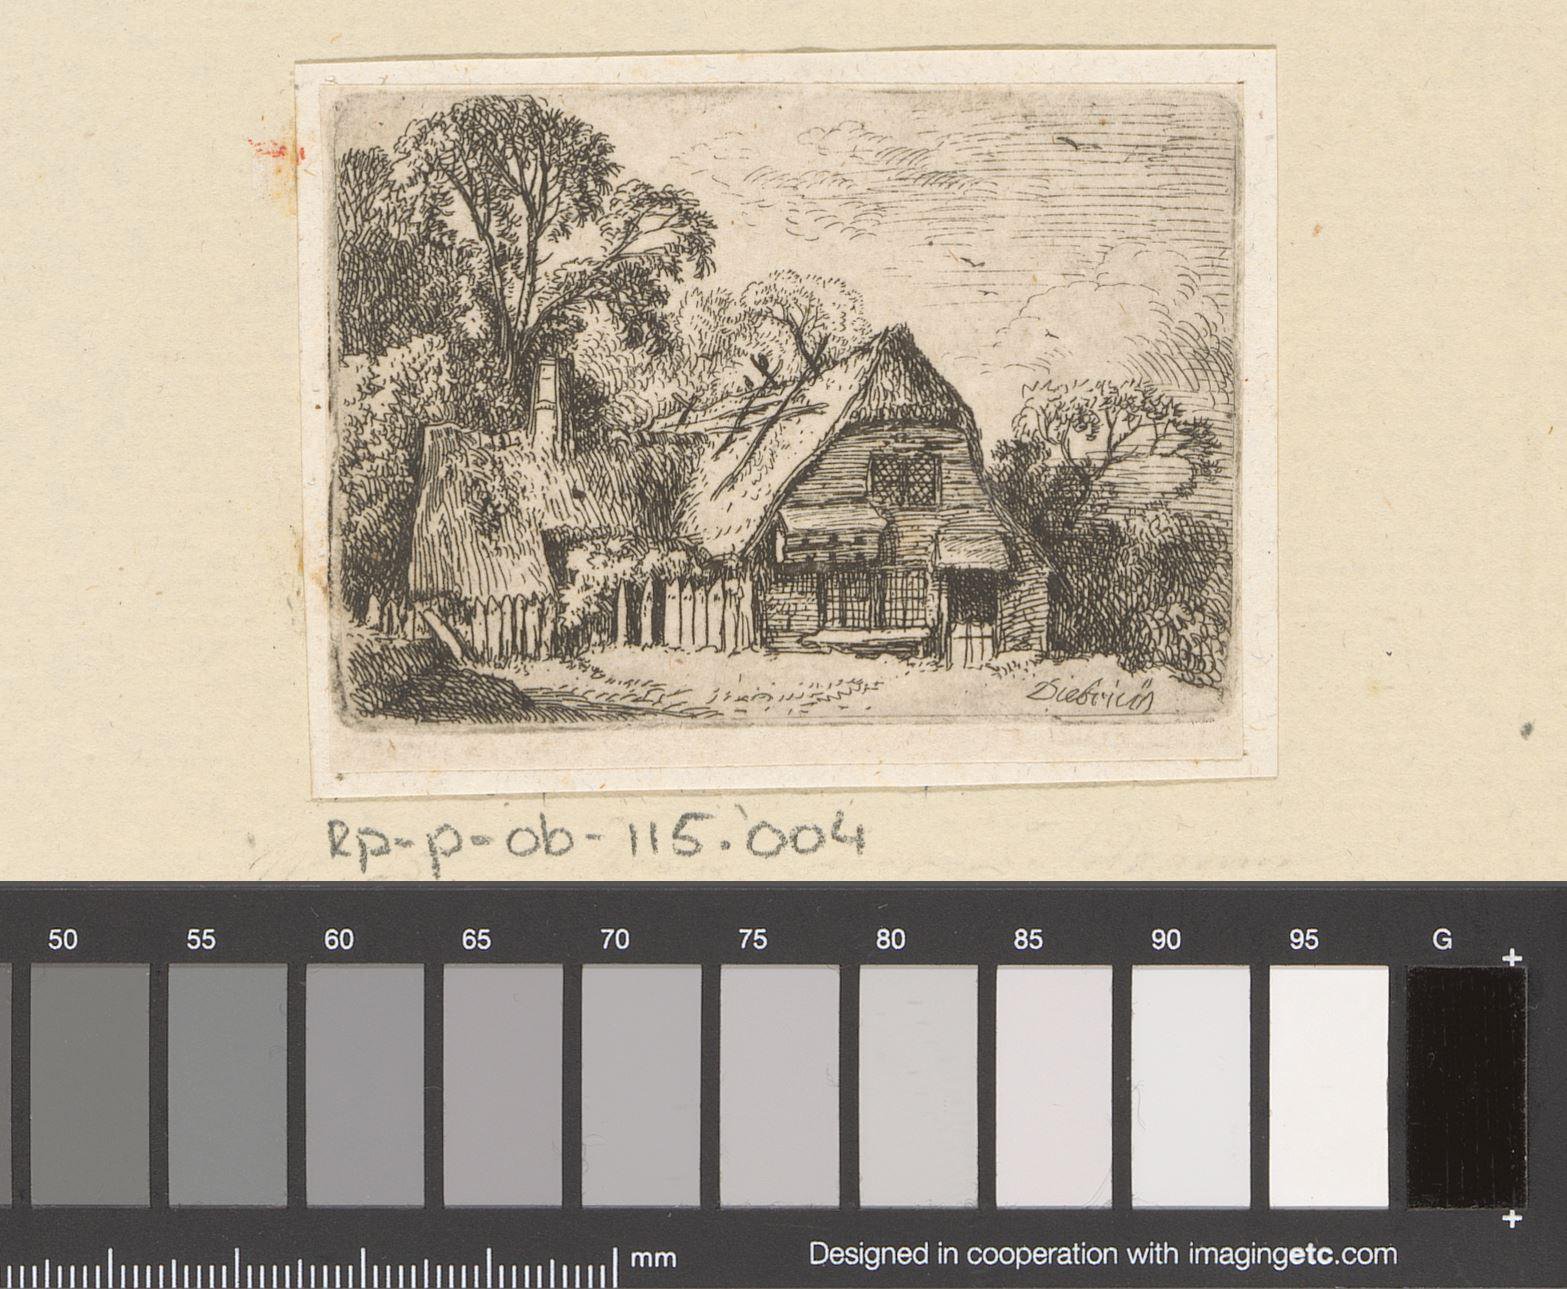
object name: print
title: Landschap met boerderij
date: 1722-1774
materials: paper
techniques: etching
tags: city-view, and landscape with man-made constructions, farm or solitary house in landscape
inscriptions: collector's mark: Lugt 240